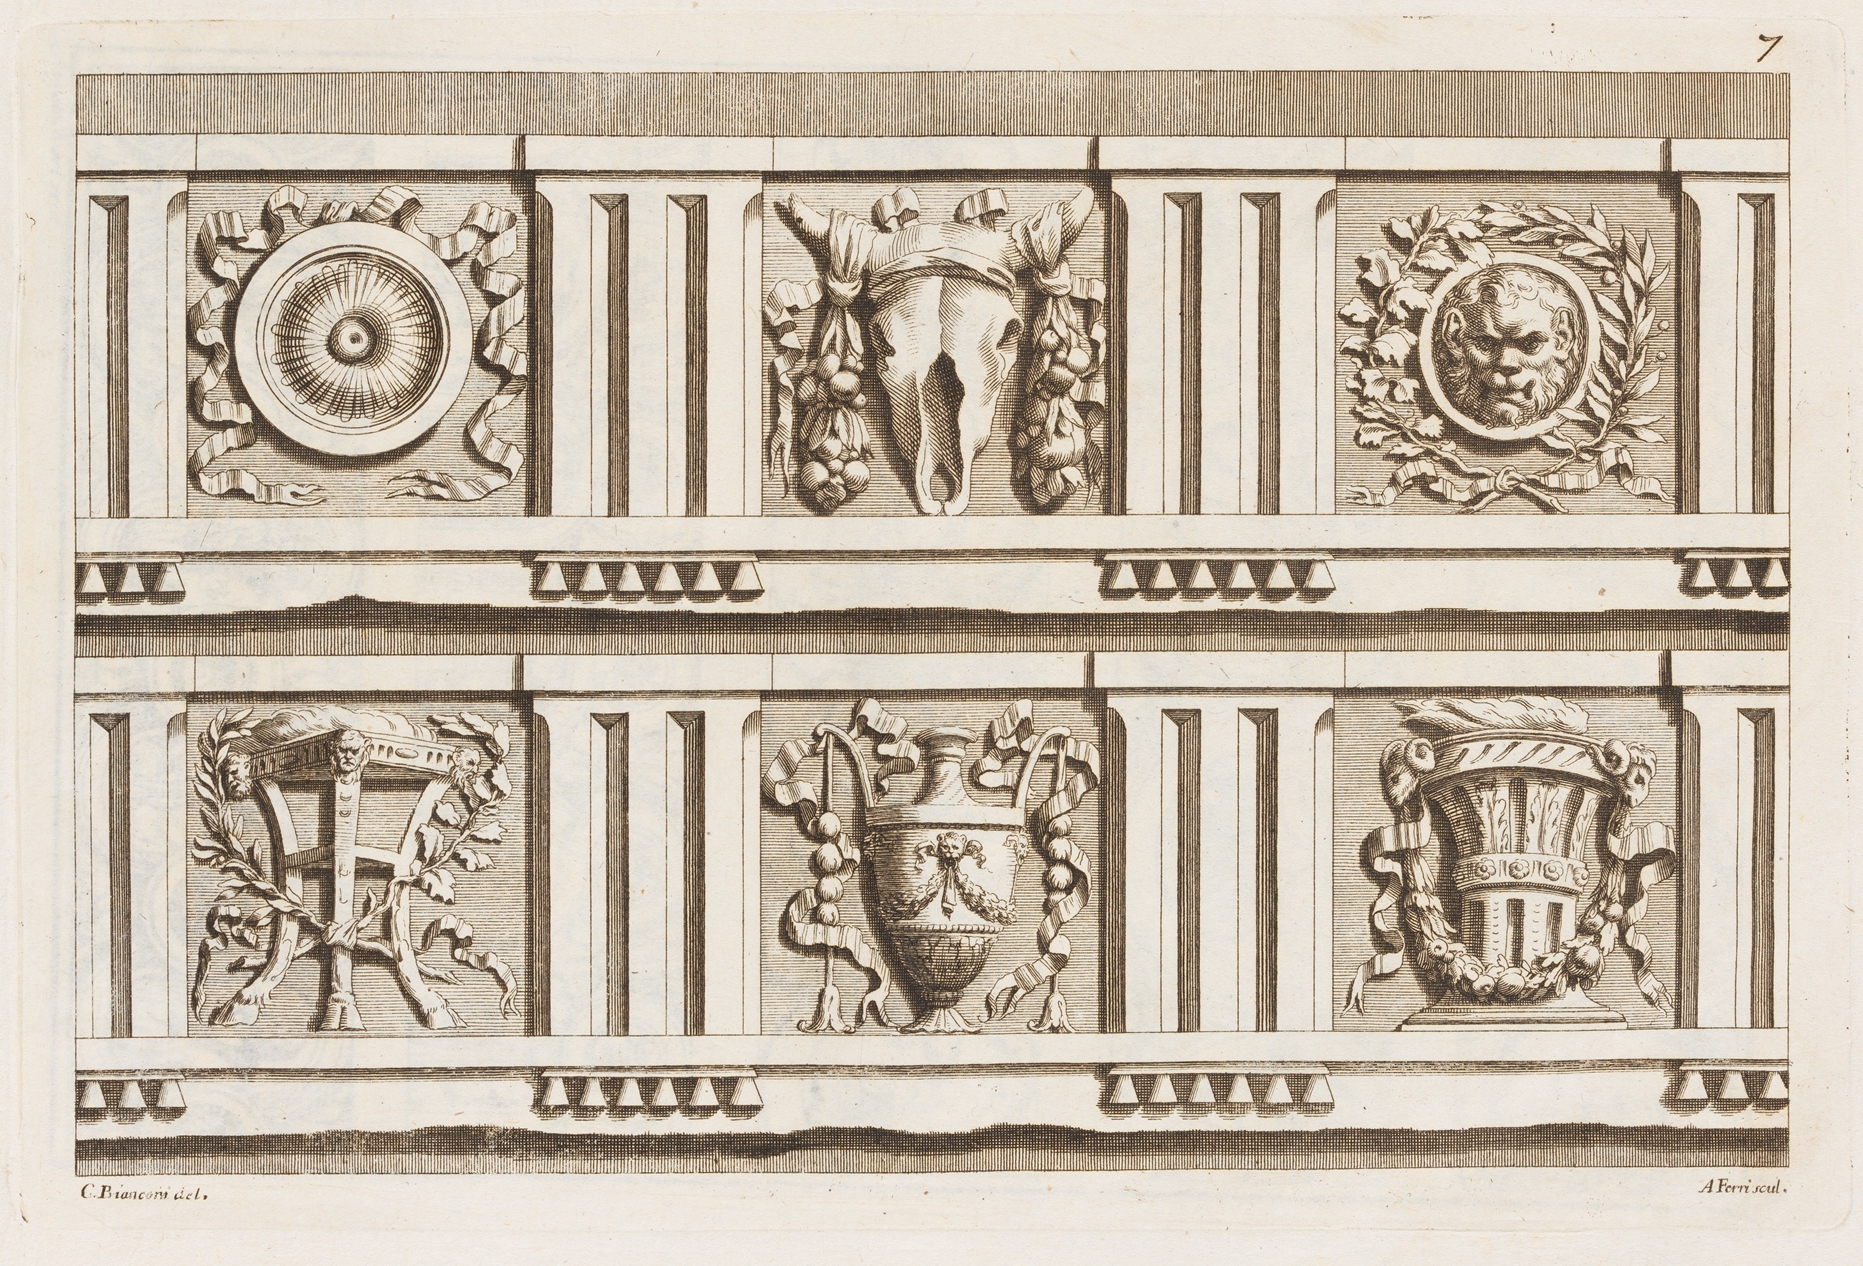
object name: book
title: Esemplare di Alcuni ornati, per la gioventù amante del Disegno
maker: carlo bianconi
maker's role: designer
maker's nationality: italian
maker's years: 1732-1802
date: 1701-1800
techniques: etching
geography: italy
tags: leaves,insignia